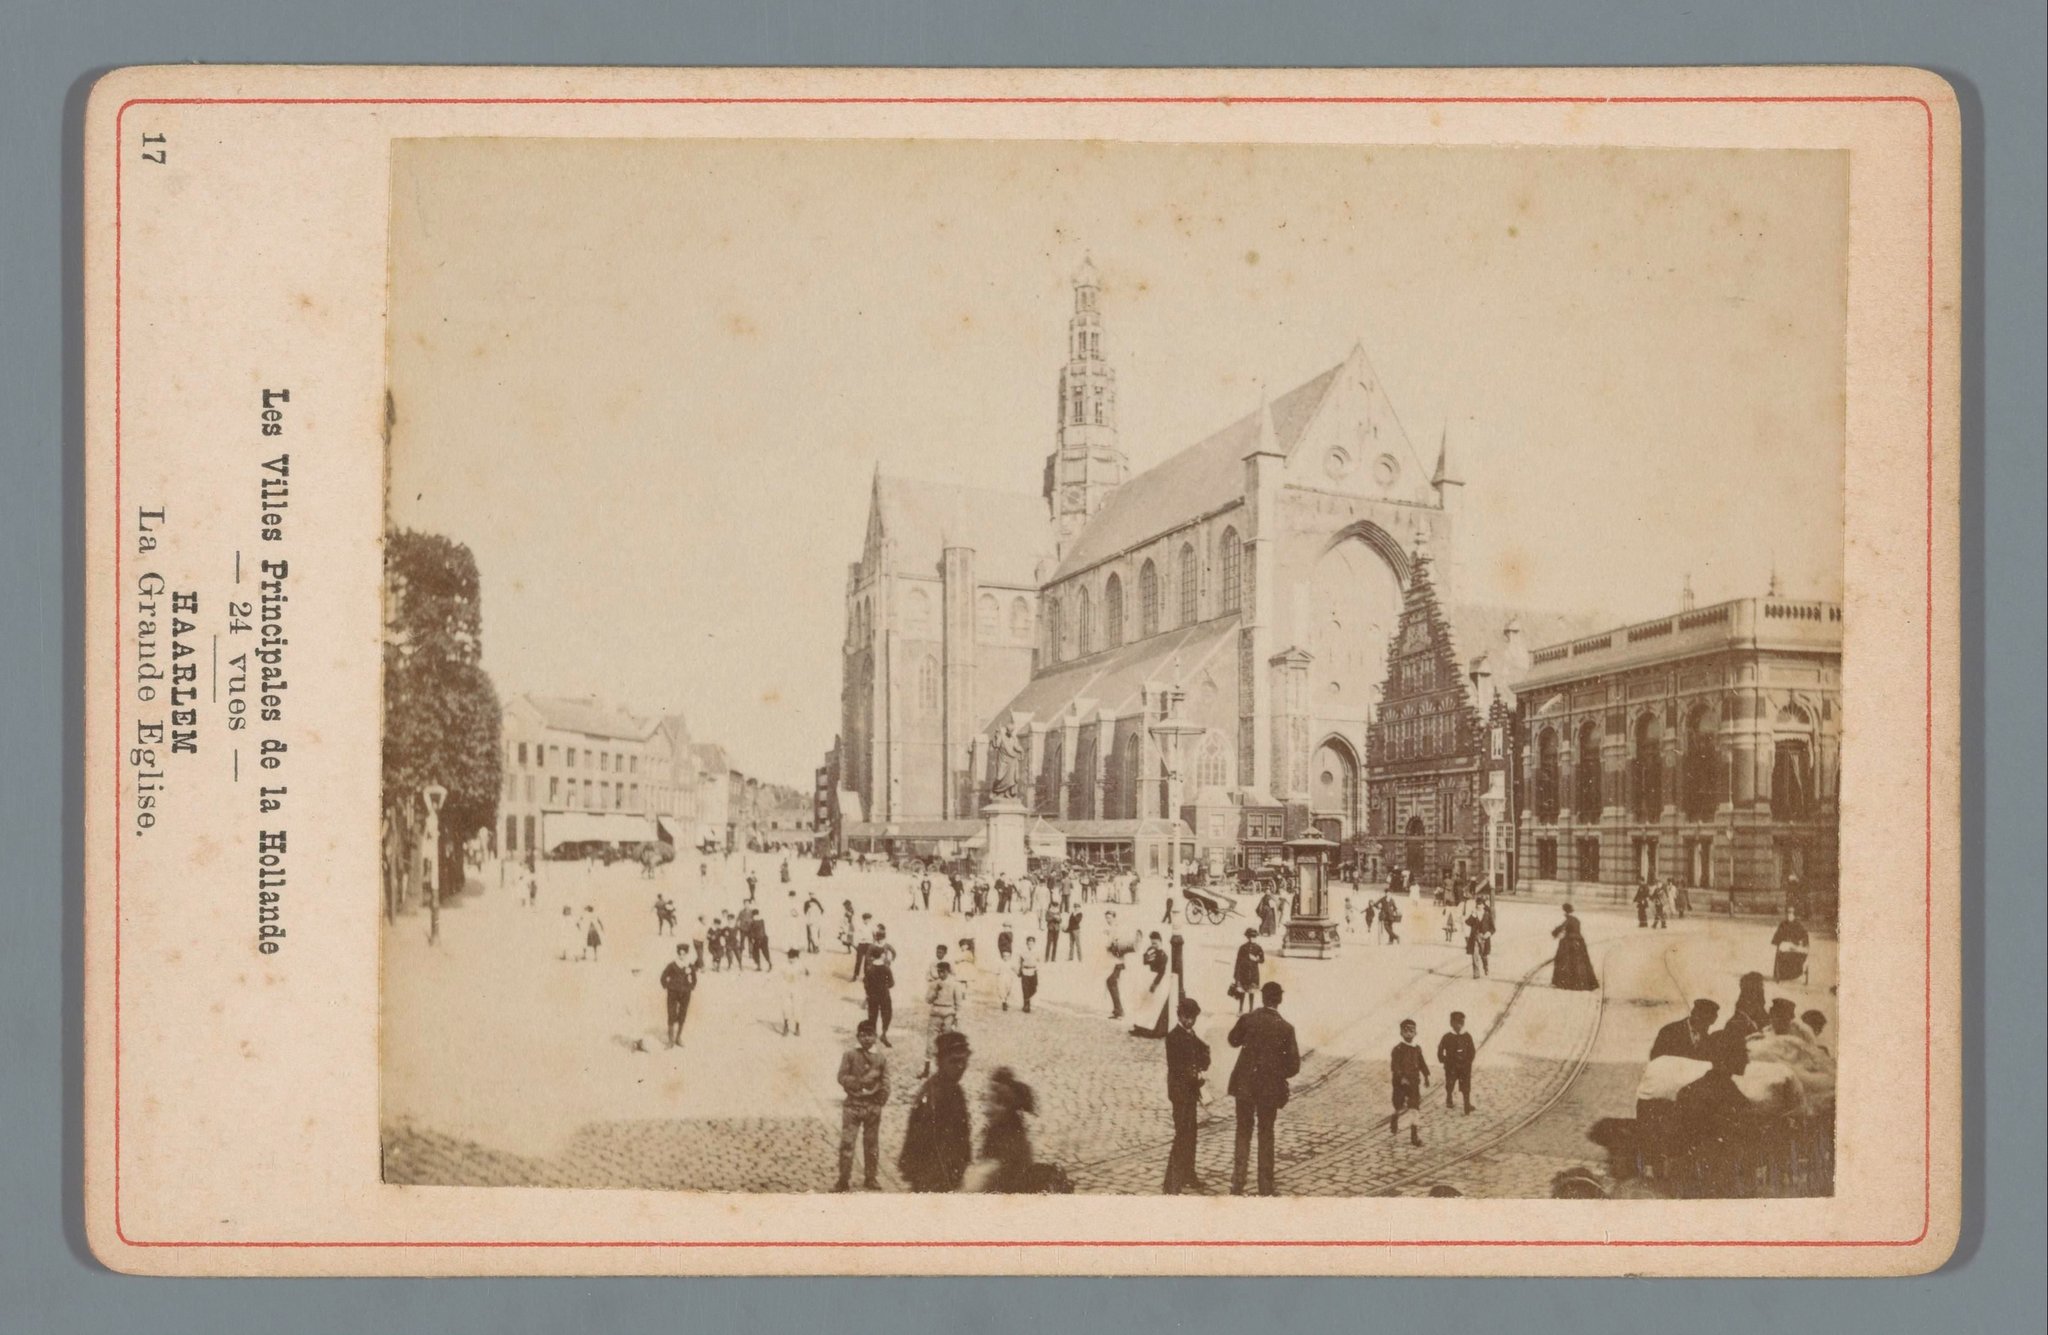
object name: photograph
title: Gezicht op de Grote Kerk of Sint-Bavokerk te Haarlem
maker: Anonymous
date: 1867-1890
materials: cardboard, photographic support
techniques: albumen print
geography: haarlem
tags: city-view in general; 'veduta', church (exterior)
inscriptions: number: ‘17.’